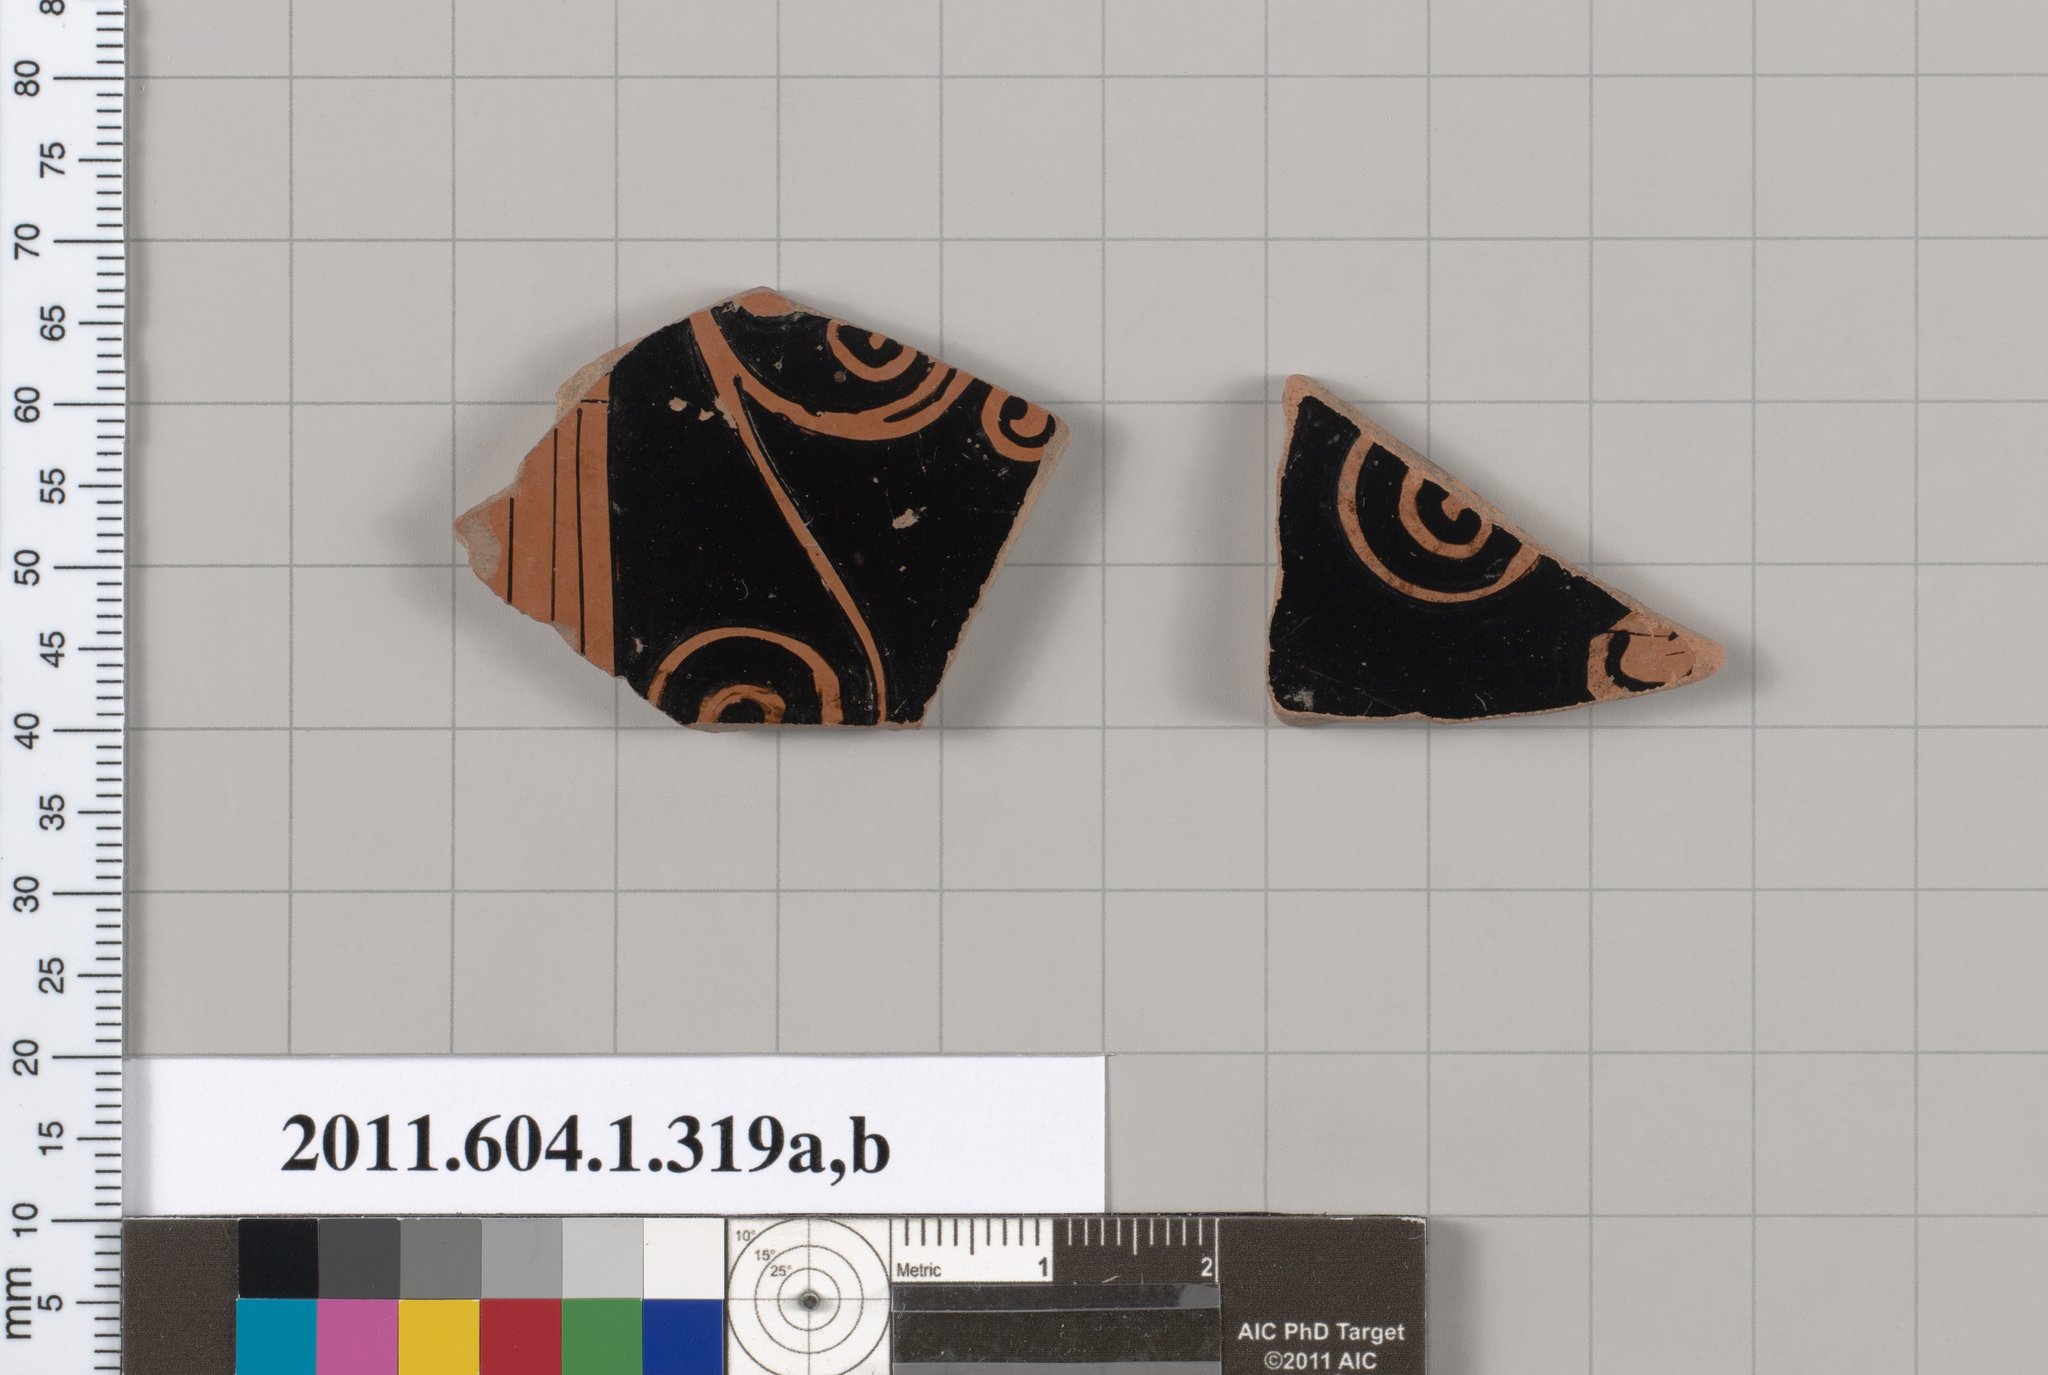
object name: kylix fragment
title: Terracotta fragments of a kylix (drinking cup)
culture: greek, attic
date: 475-451 BCE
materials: terracotta